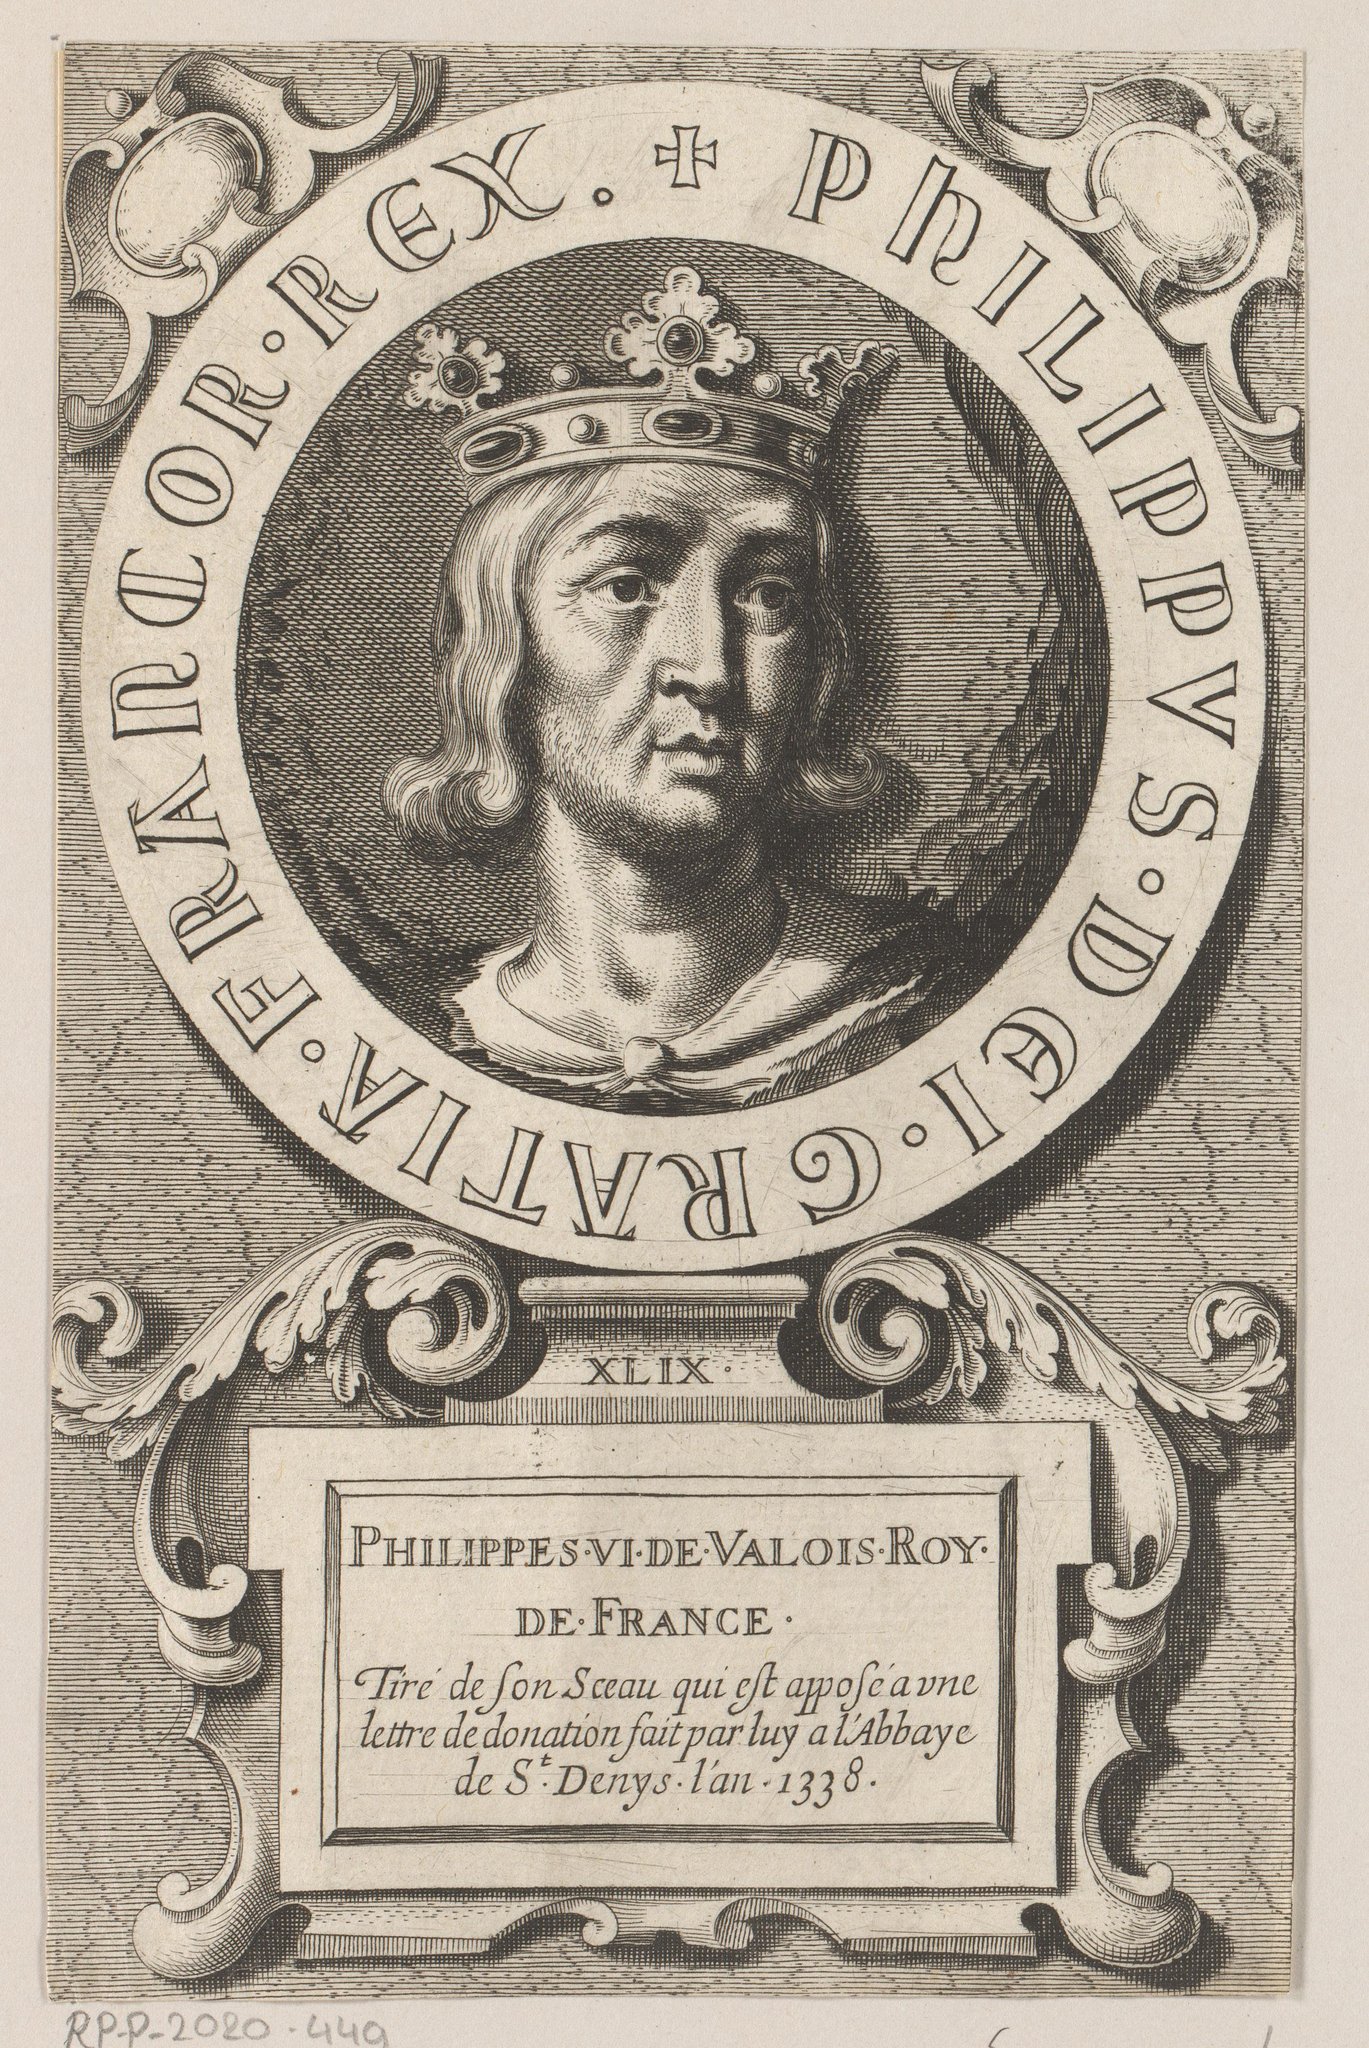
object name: print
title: Portret van Filips VI, koning van Frankrijk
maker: jacques de bie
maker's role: print maker, publisher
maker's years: 1581-1647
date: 1634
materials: paper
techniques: engraving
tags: historical persons, ruler, sovereign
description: Prent waarschijnlijk voor het eerst verschenen in: Bie, Jacques de. Les vrais portraits des rois de France (...). 3 dln. Parijs: Jacques de Bie en Pierre Rocolet, 1634, dl. 2. Prent ook gebruikt in latere publicaties.